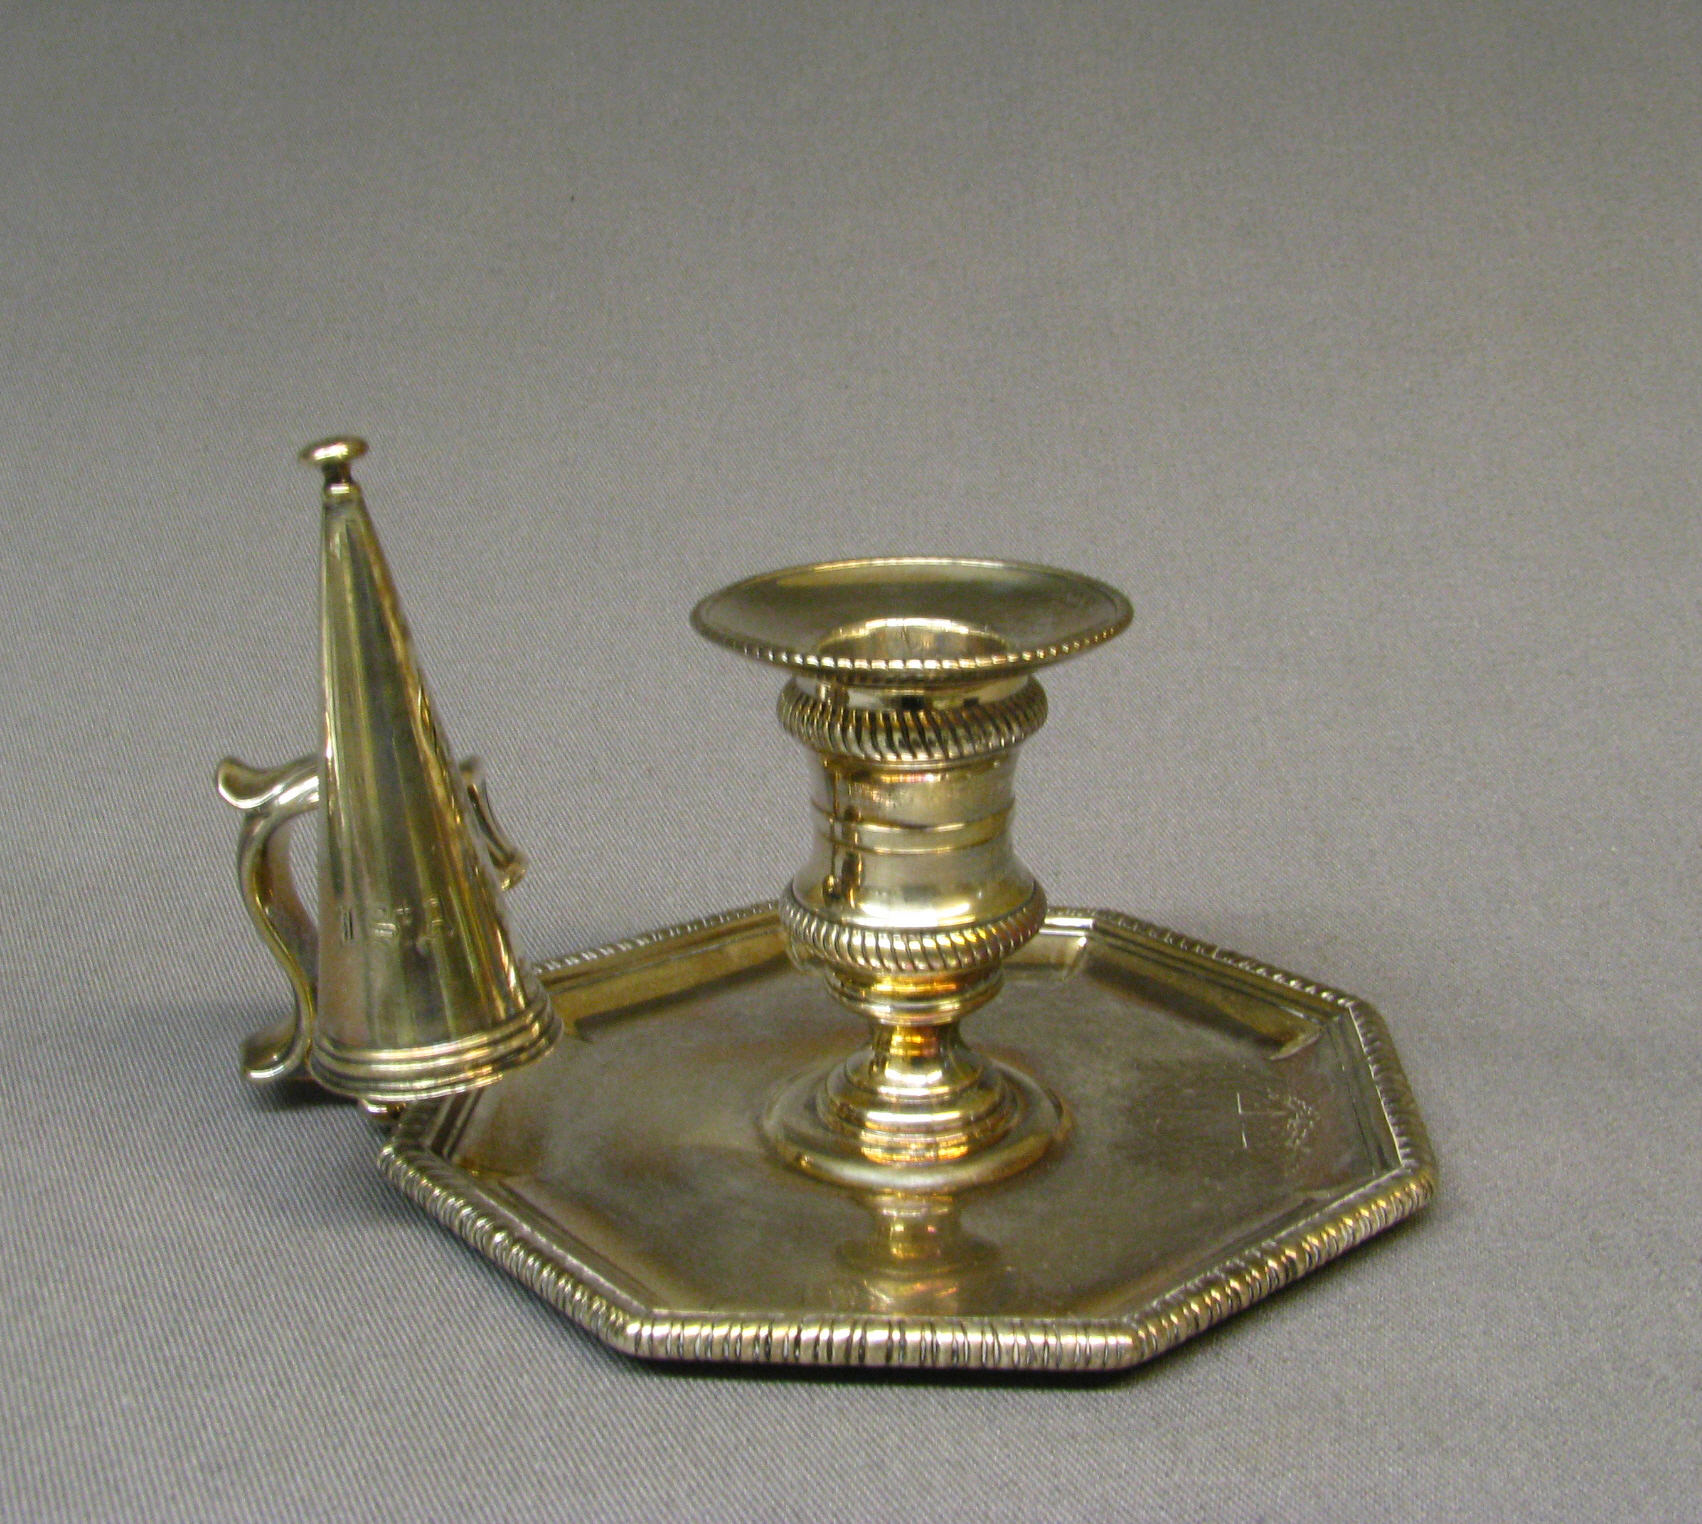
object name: chamber candlestick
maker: john parker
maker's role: maker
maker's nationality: british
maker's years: 1759-1777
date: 1762-1763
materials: silver